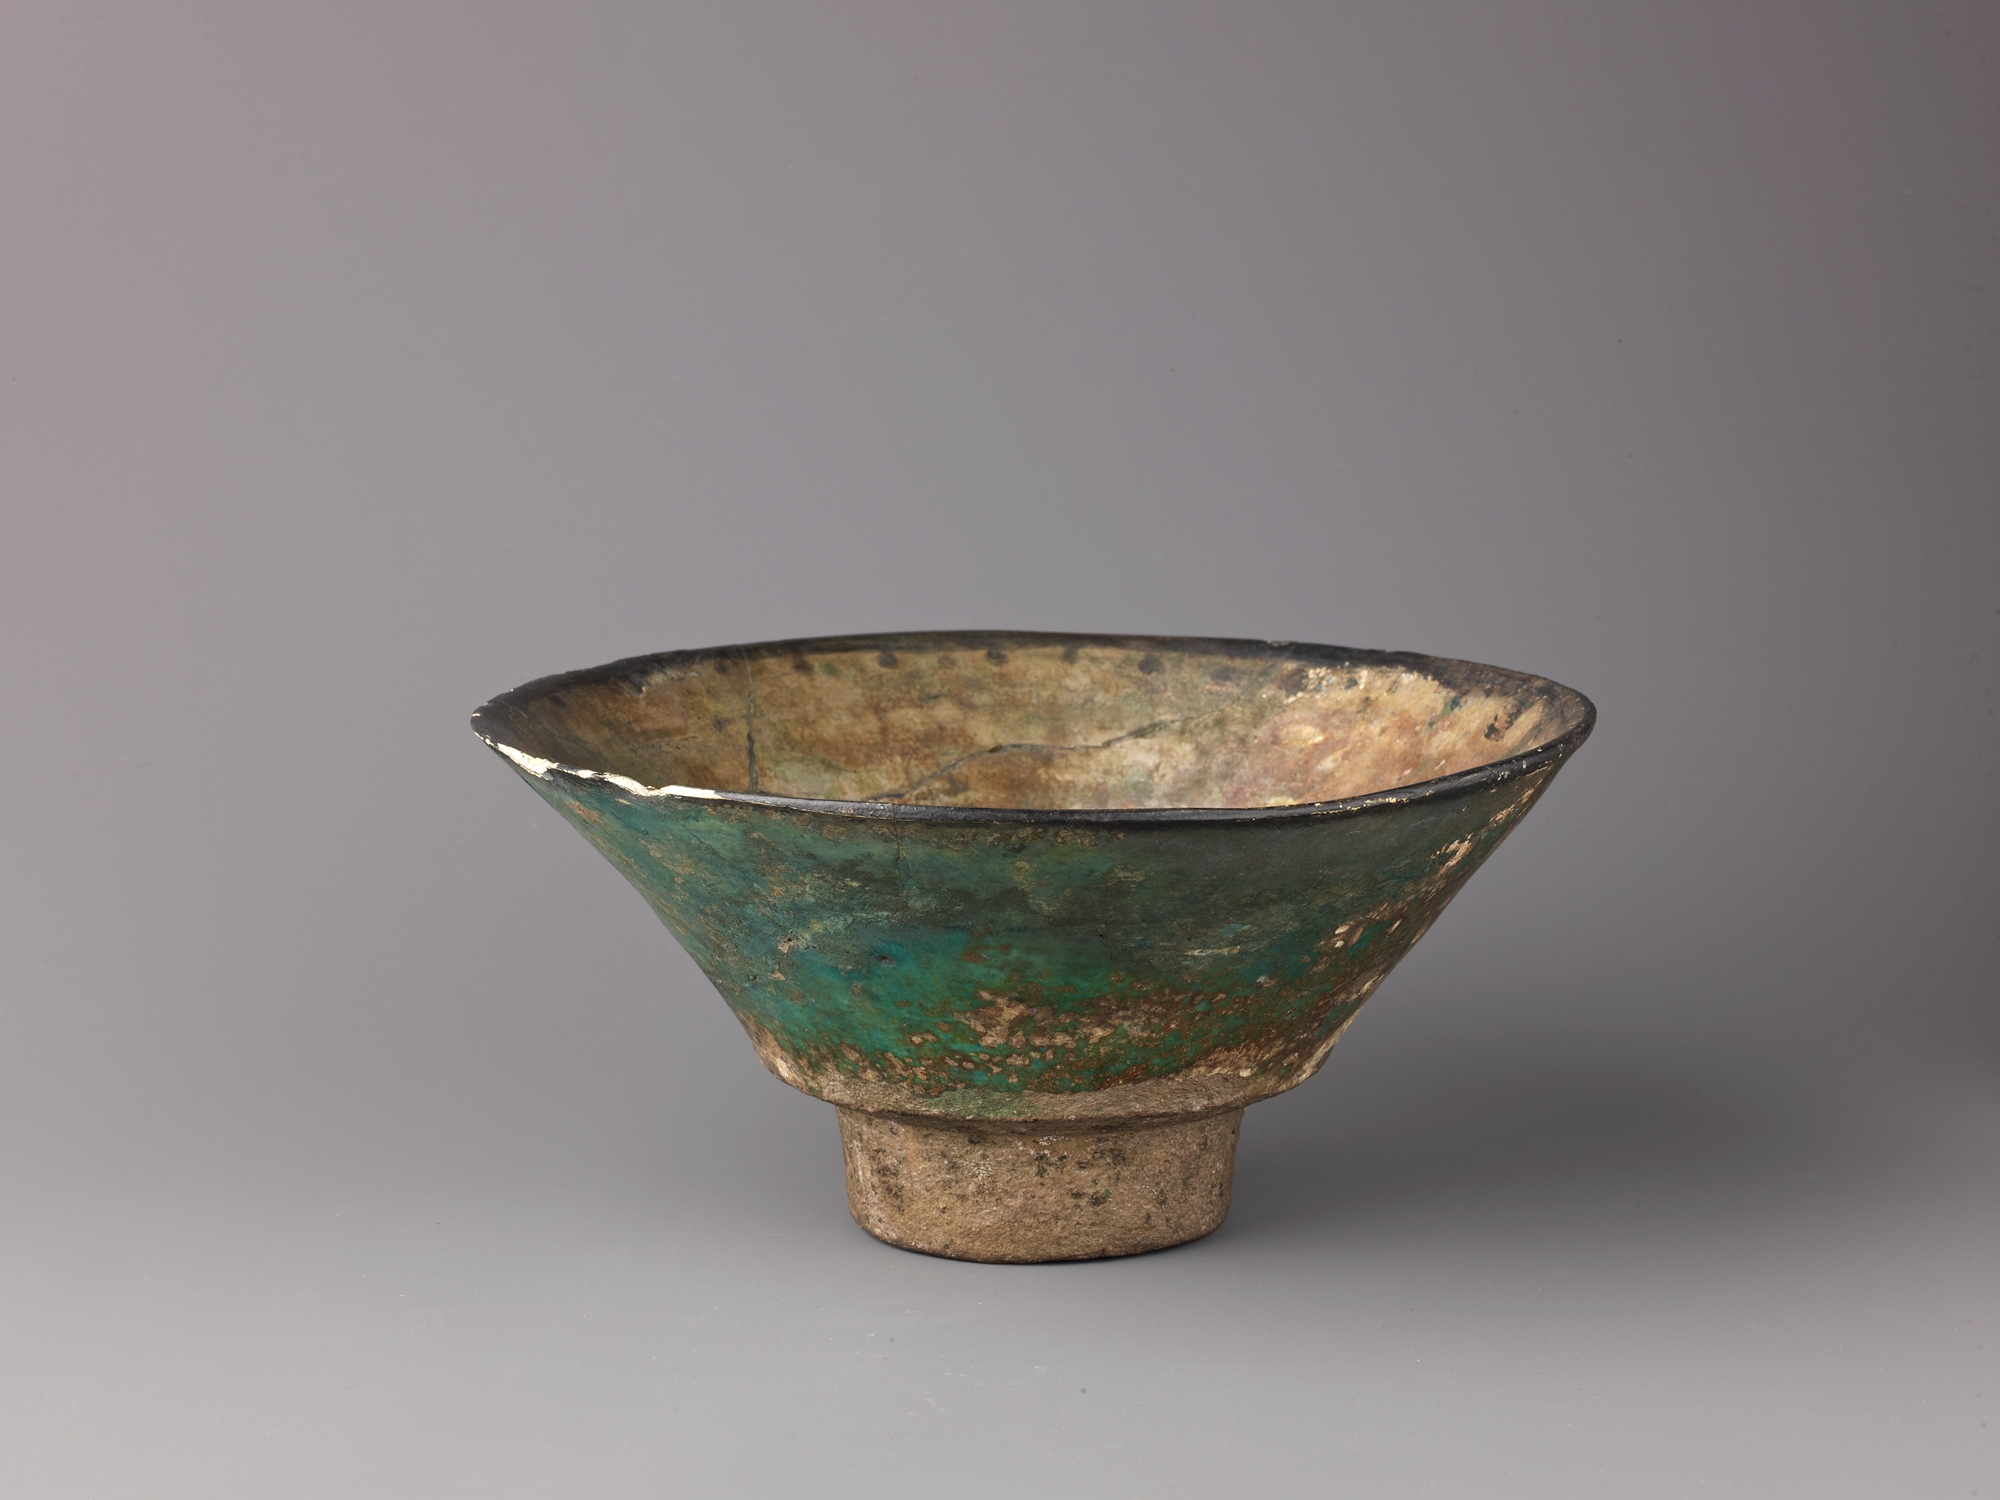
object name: bowl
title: Biconical bowl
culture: syrian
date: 1201-1250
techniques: painting, underglaze